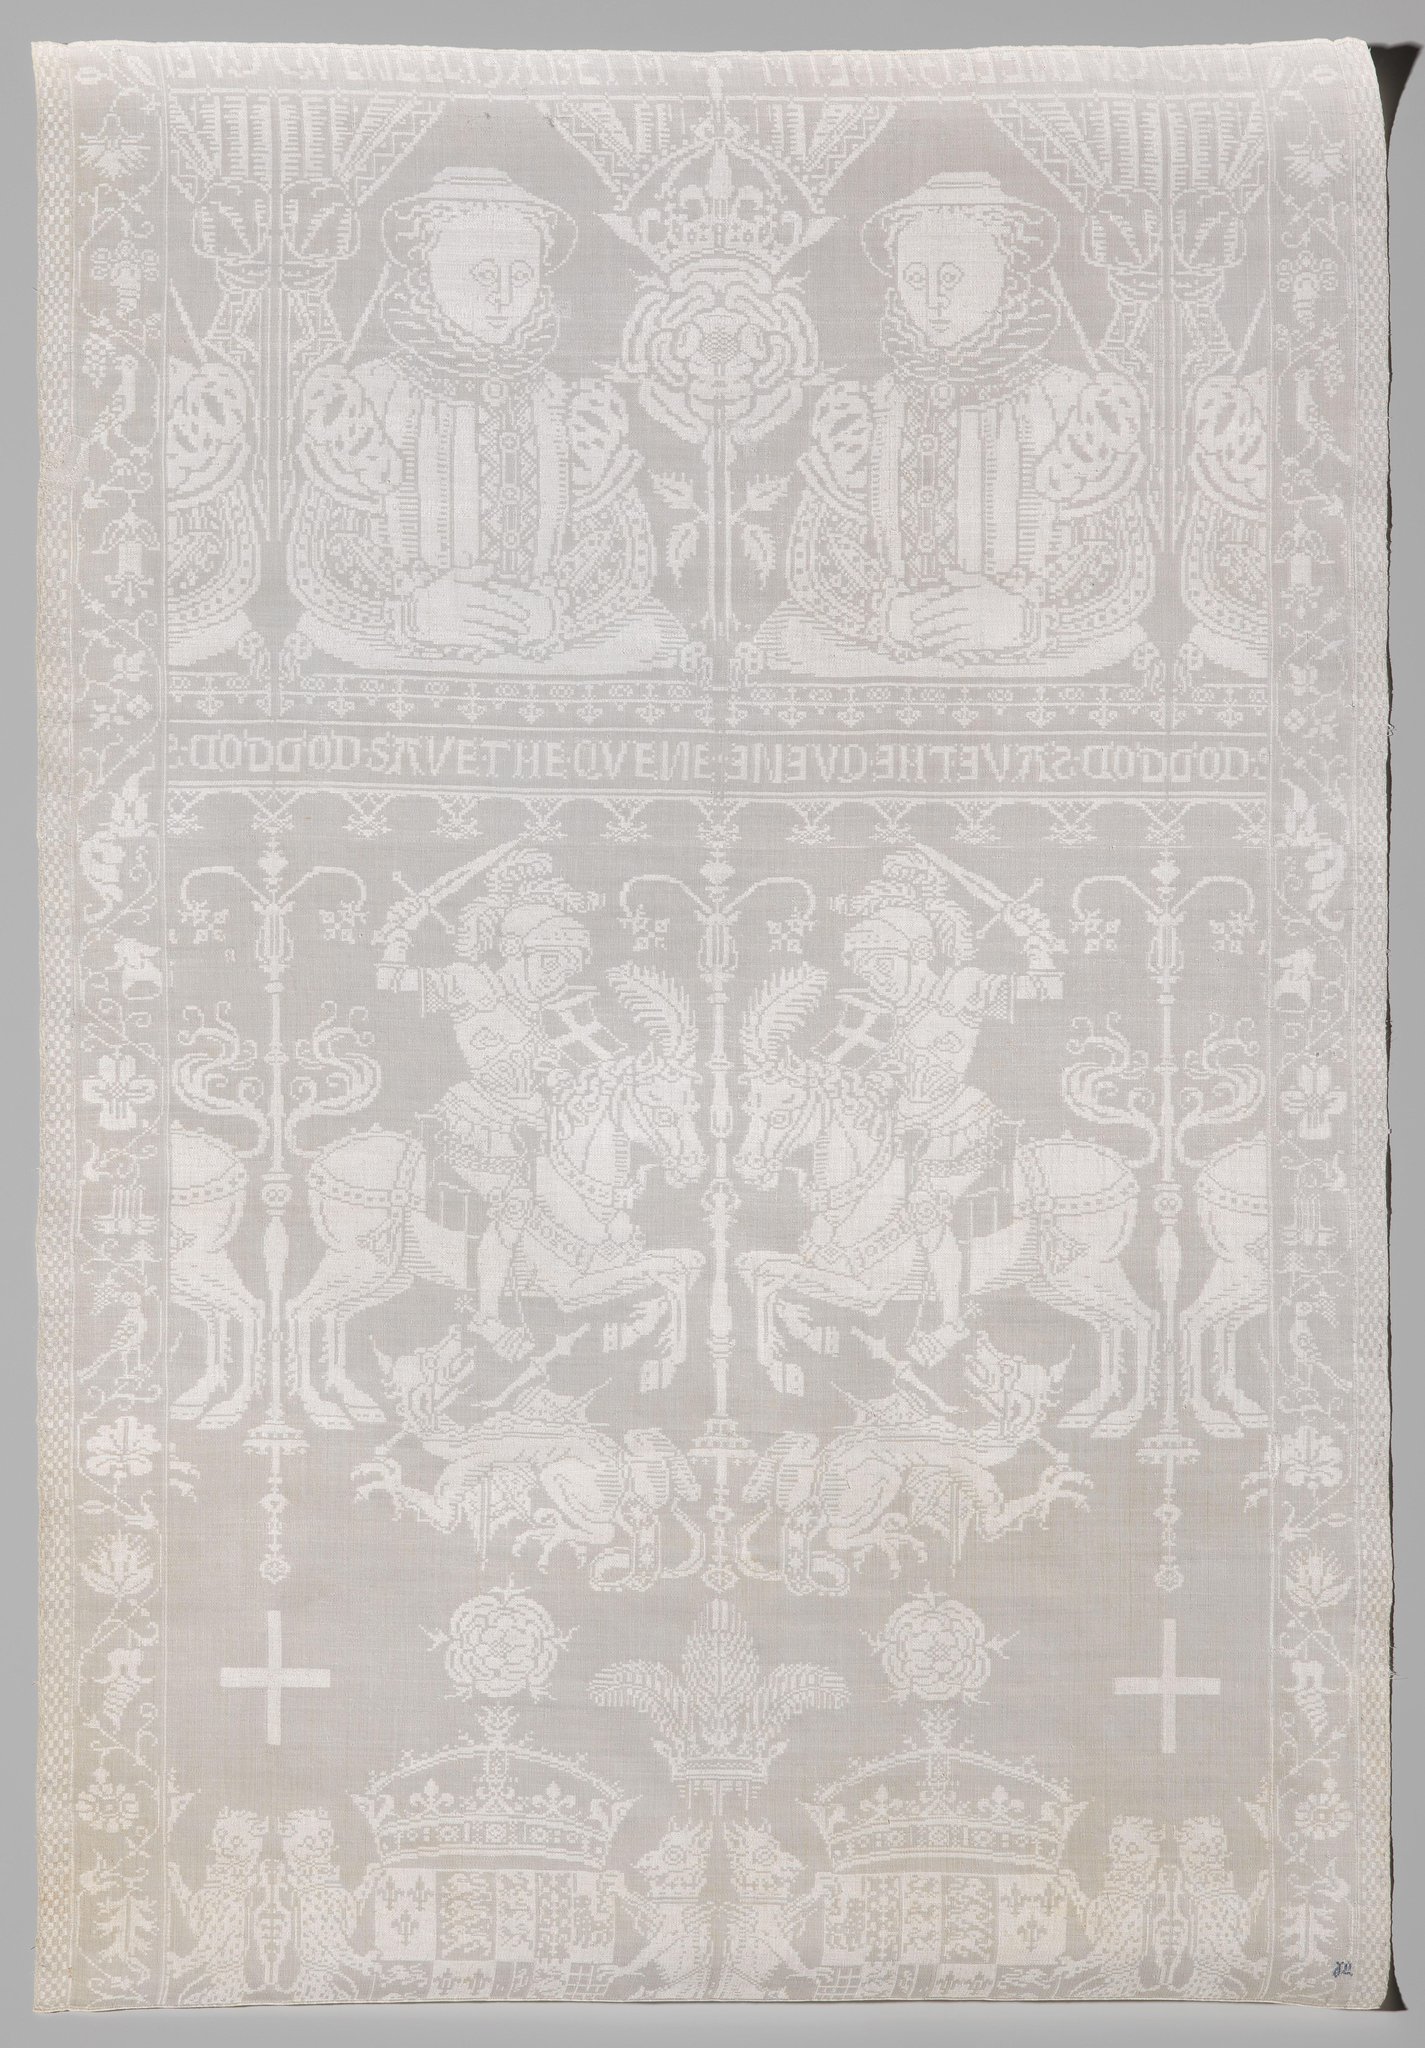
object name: napkin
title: Servet van wit linnendamast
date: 1550-1599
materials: linen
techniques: damask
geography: flanders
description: Wit linnen damasten servet met het portret en het wapen van koningin Elisabeth I van Engeland